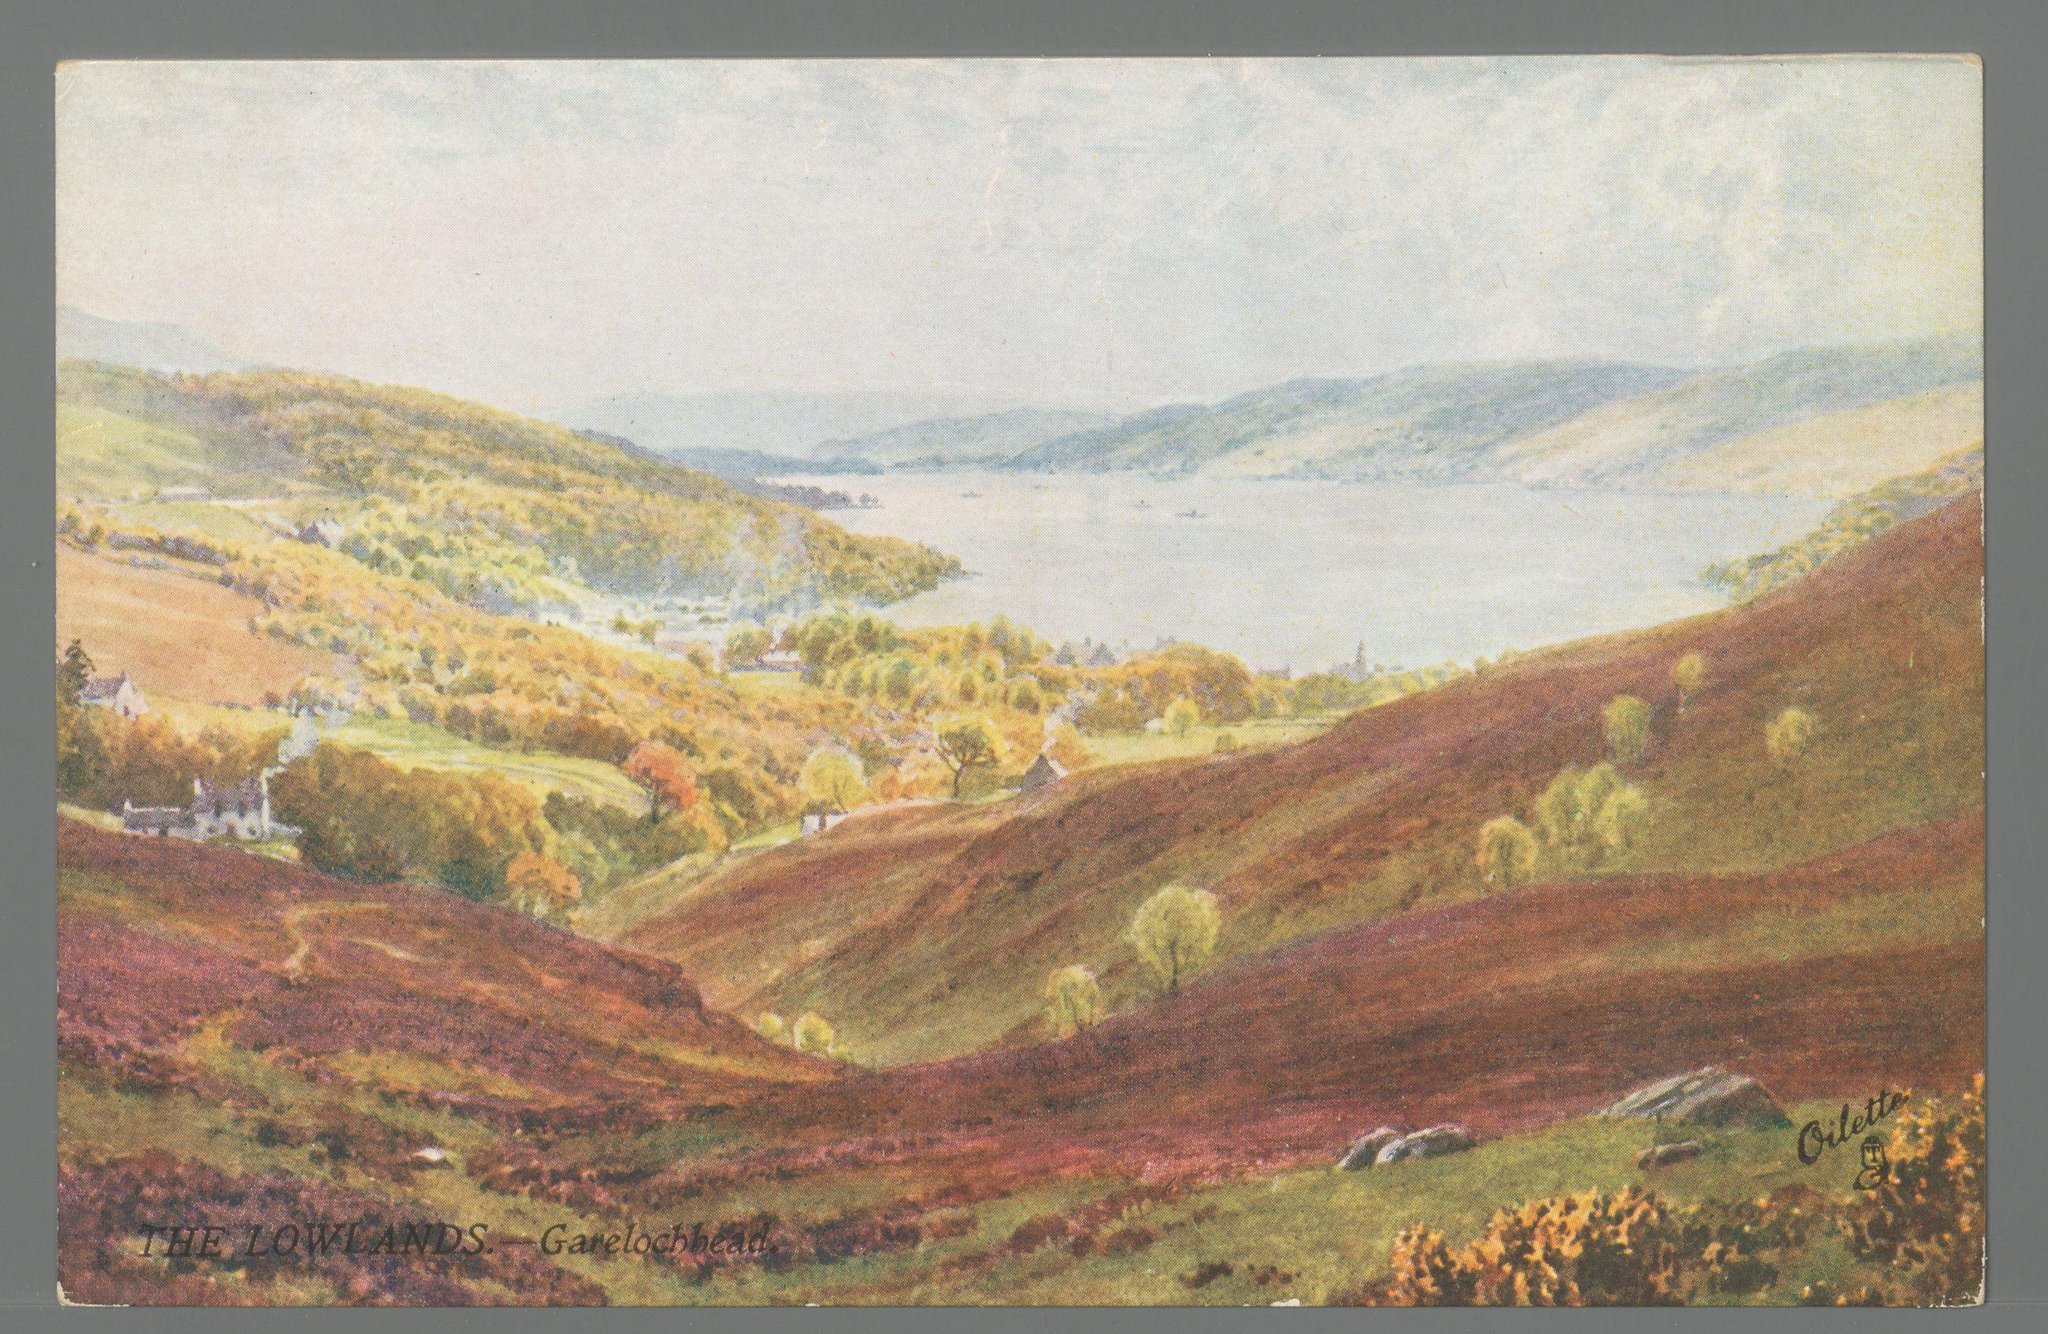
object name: photomechanical print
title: The Lowlands.- Garelochhead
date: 1906-1912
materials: cardboard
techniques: color autotype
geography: england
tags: lake, mountains